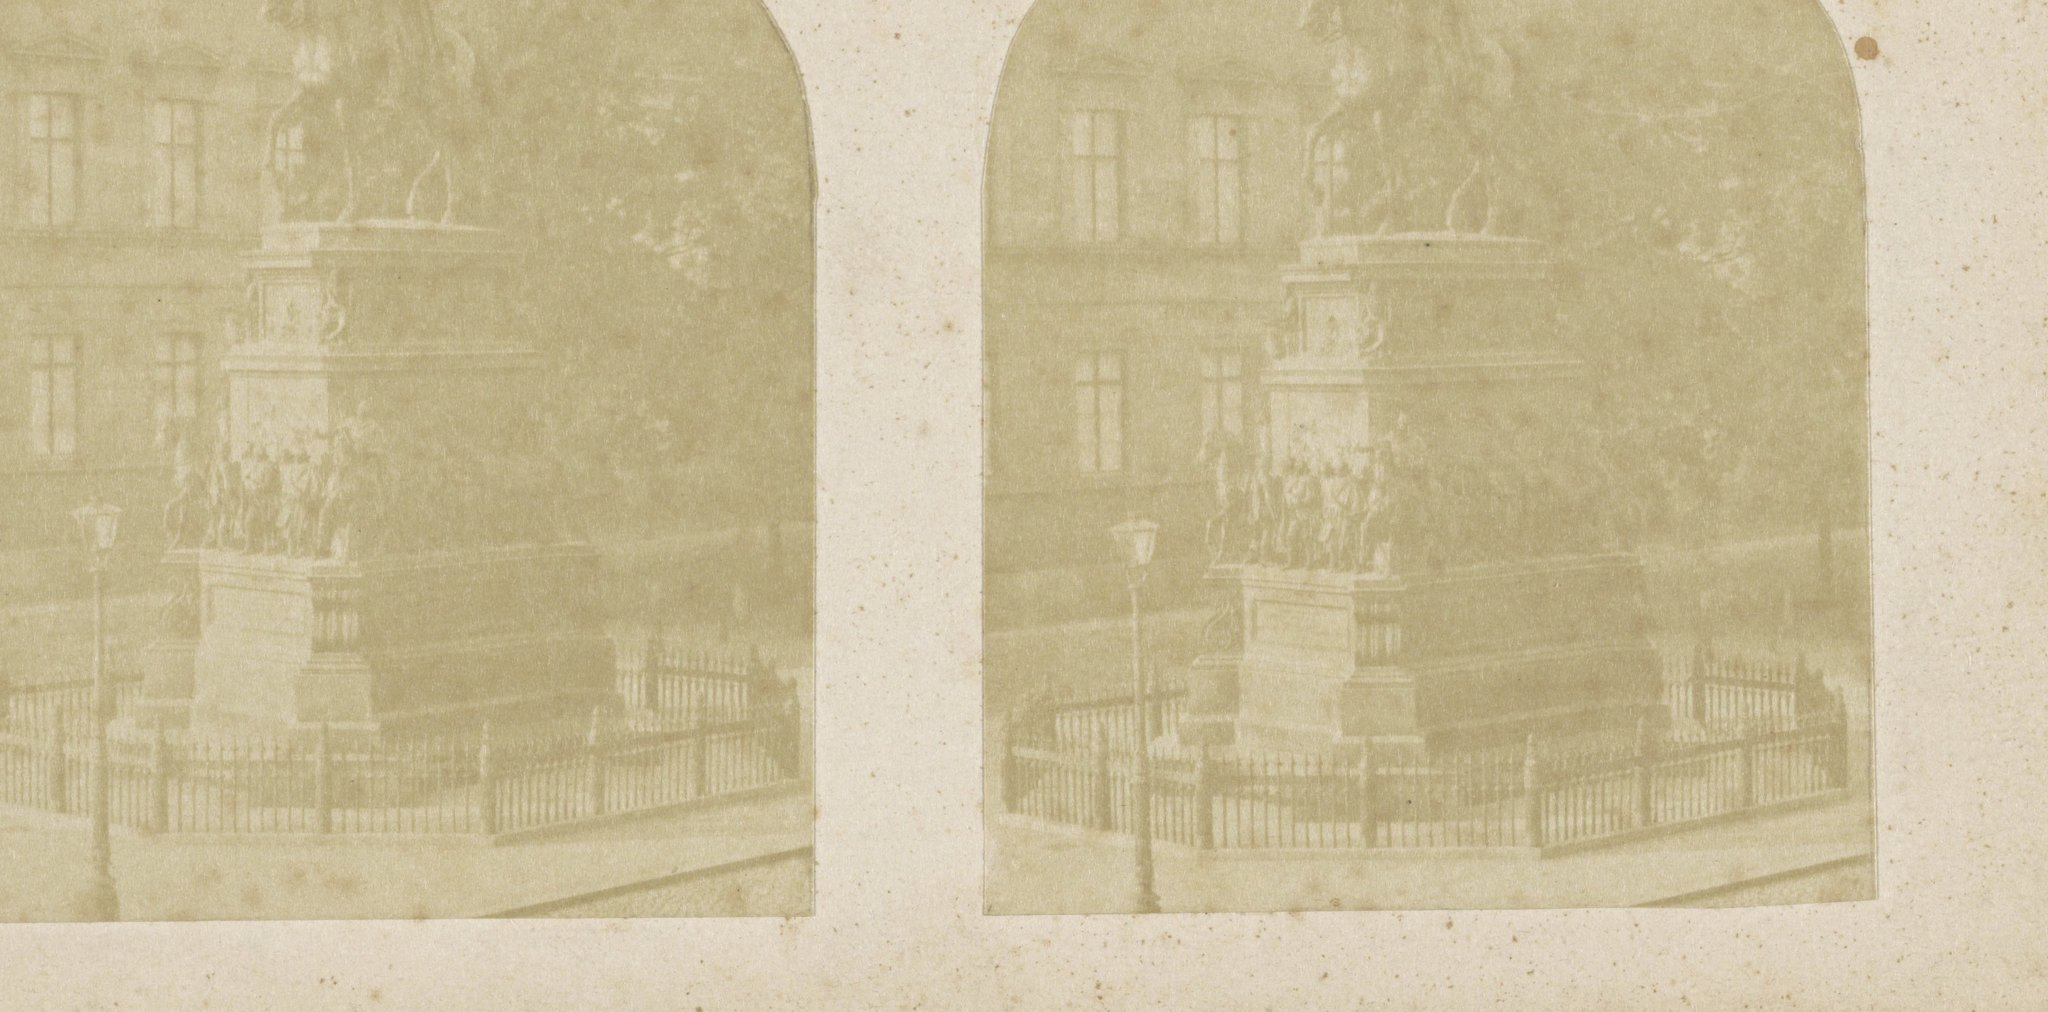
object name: stereograph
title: Ruiterstandbeeld van Frederik de Grote in Berlijn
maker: Anonymous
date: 1852-1863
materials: cardboard, paper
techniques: albumen print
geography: berlin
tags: berlin, frederick ii (king of prussia), equestrian statue